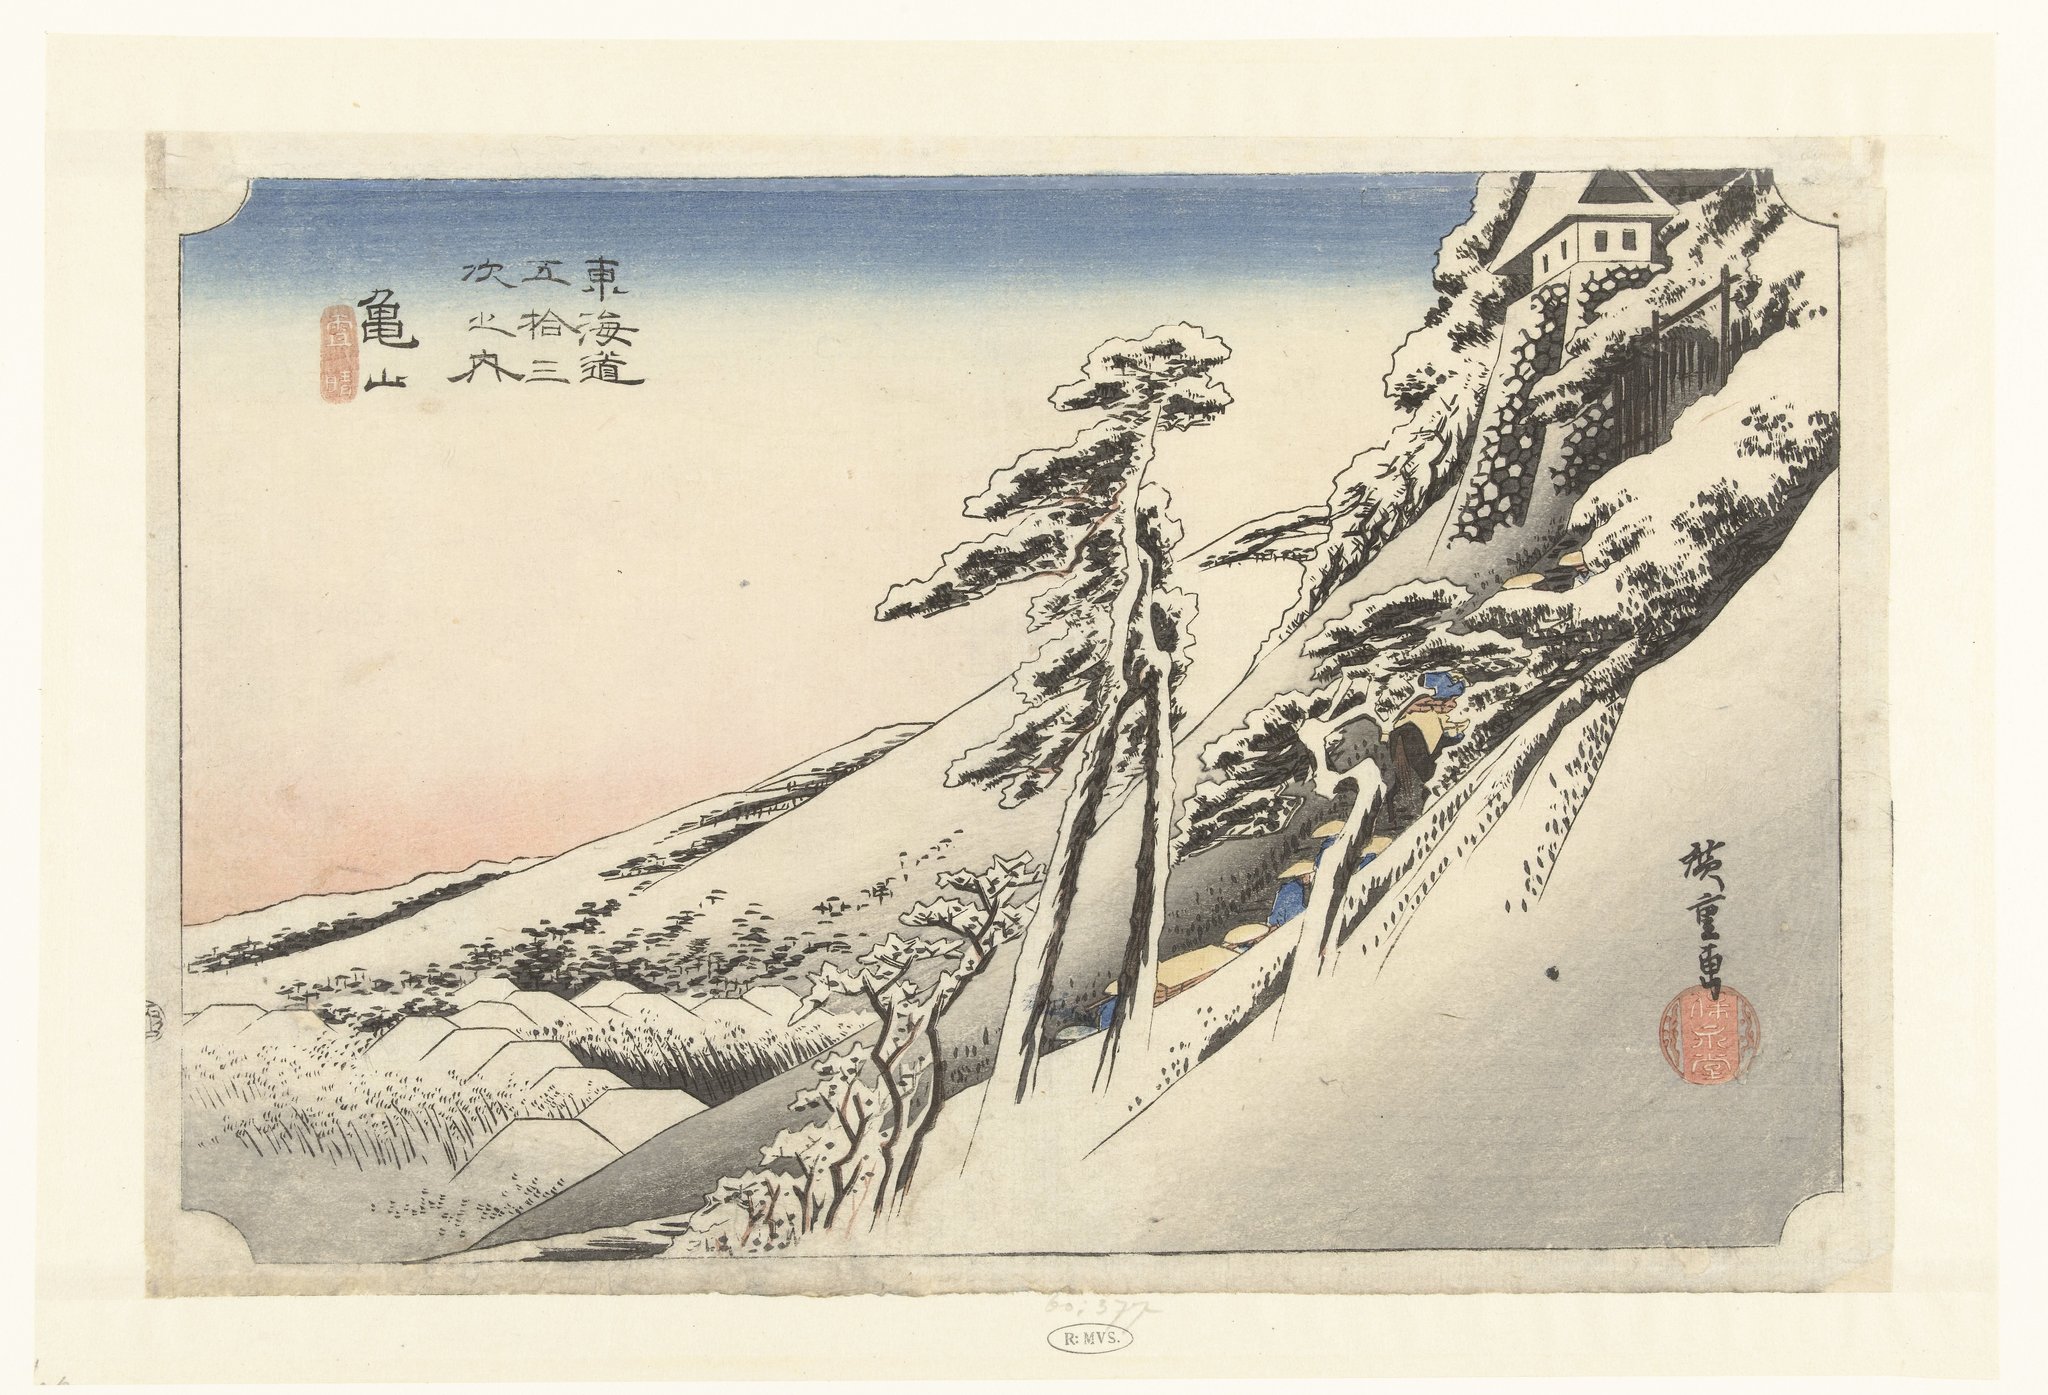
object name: print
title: Kamayama, yukibare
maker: utagawa hiroshige (i)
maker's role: draughtsman, print maker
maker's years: 1797-1858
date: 1828-1835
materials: paper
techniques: woodcut, nishiki e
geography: japan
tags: mountain climbing, mountaineering, castle, snow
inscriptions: collector's mark: Lugt 2228, signature: ‘Hiroshige ga’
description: Sneeuwlandschap met een groep reizigers, in blauw en geel, een stijl bergpad beklimmend, leidend naar het Kameyama kasteel rechtsboven; linksonder de daken van huizen.